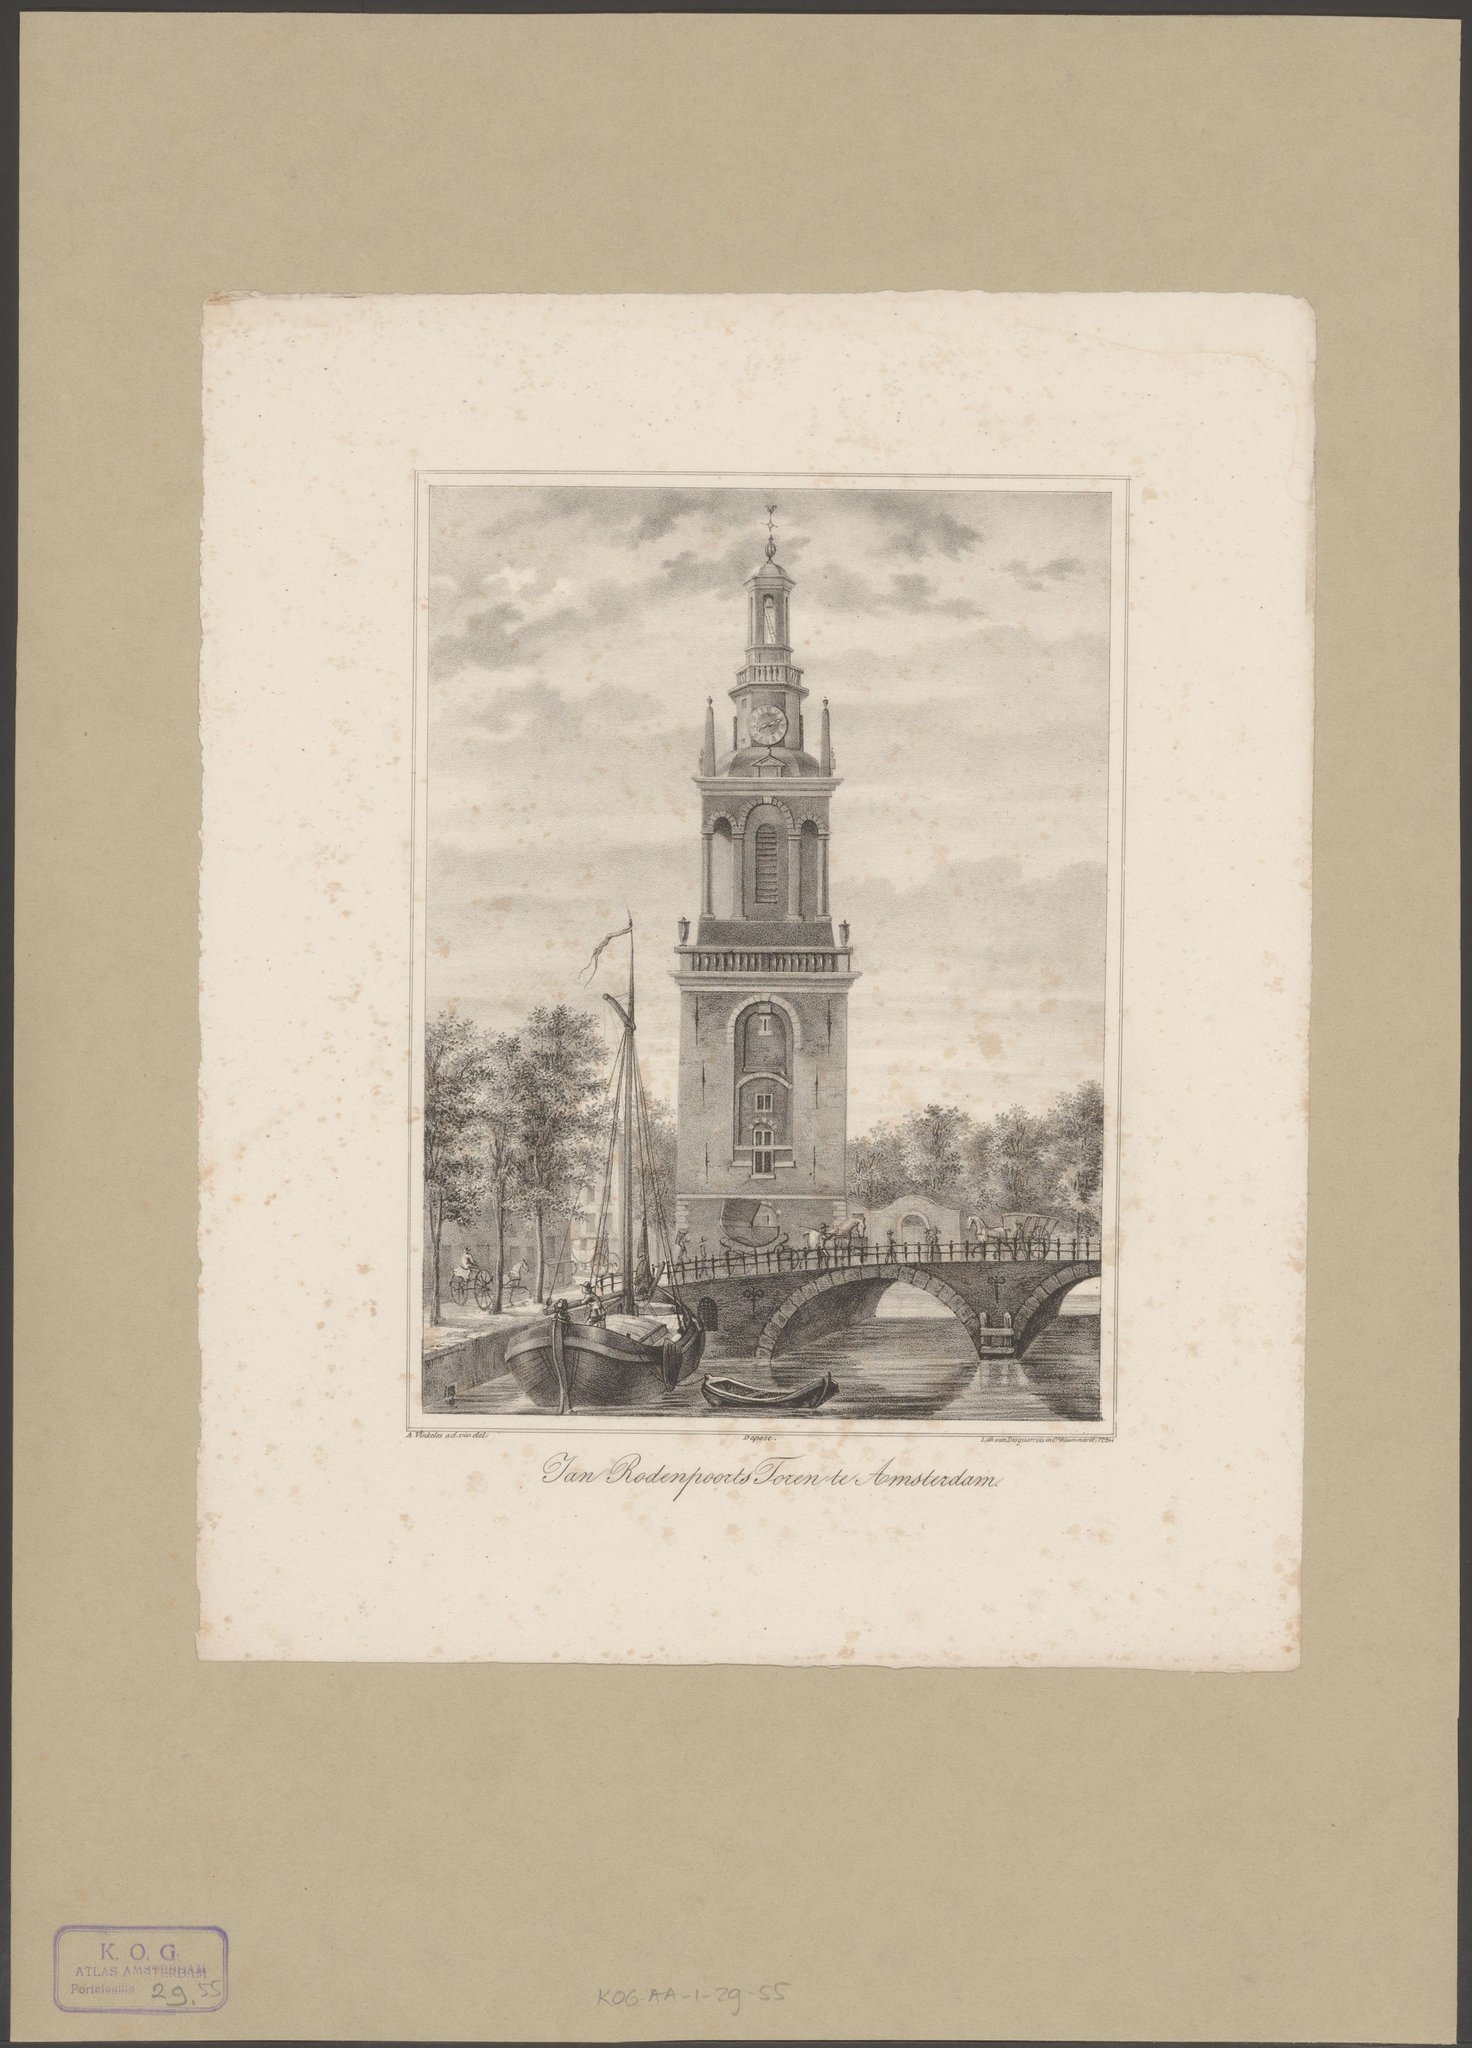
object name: print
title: Gezichten van de Zes Voornaamste Torens der Stad Amsterdam. 2de Cahier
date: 1828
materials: paper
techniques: lithograph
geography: amsterdam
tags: bridge in city across river, canal, etc. (+ city(-scape) with figures, staffage), sailing-ship, sailing-boat, tower, clock tower ~ monumental adornment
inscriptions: : ‘Déposé. ’, collector's mark: Lugt 1641b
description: Prent maakt onderdeel uit van de serie: Gezichten van de Zes Voornaamste Torens der Stad Amsterdam. 2de Cahier. Amsterdam: Desguerrois & Co., [1828].